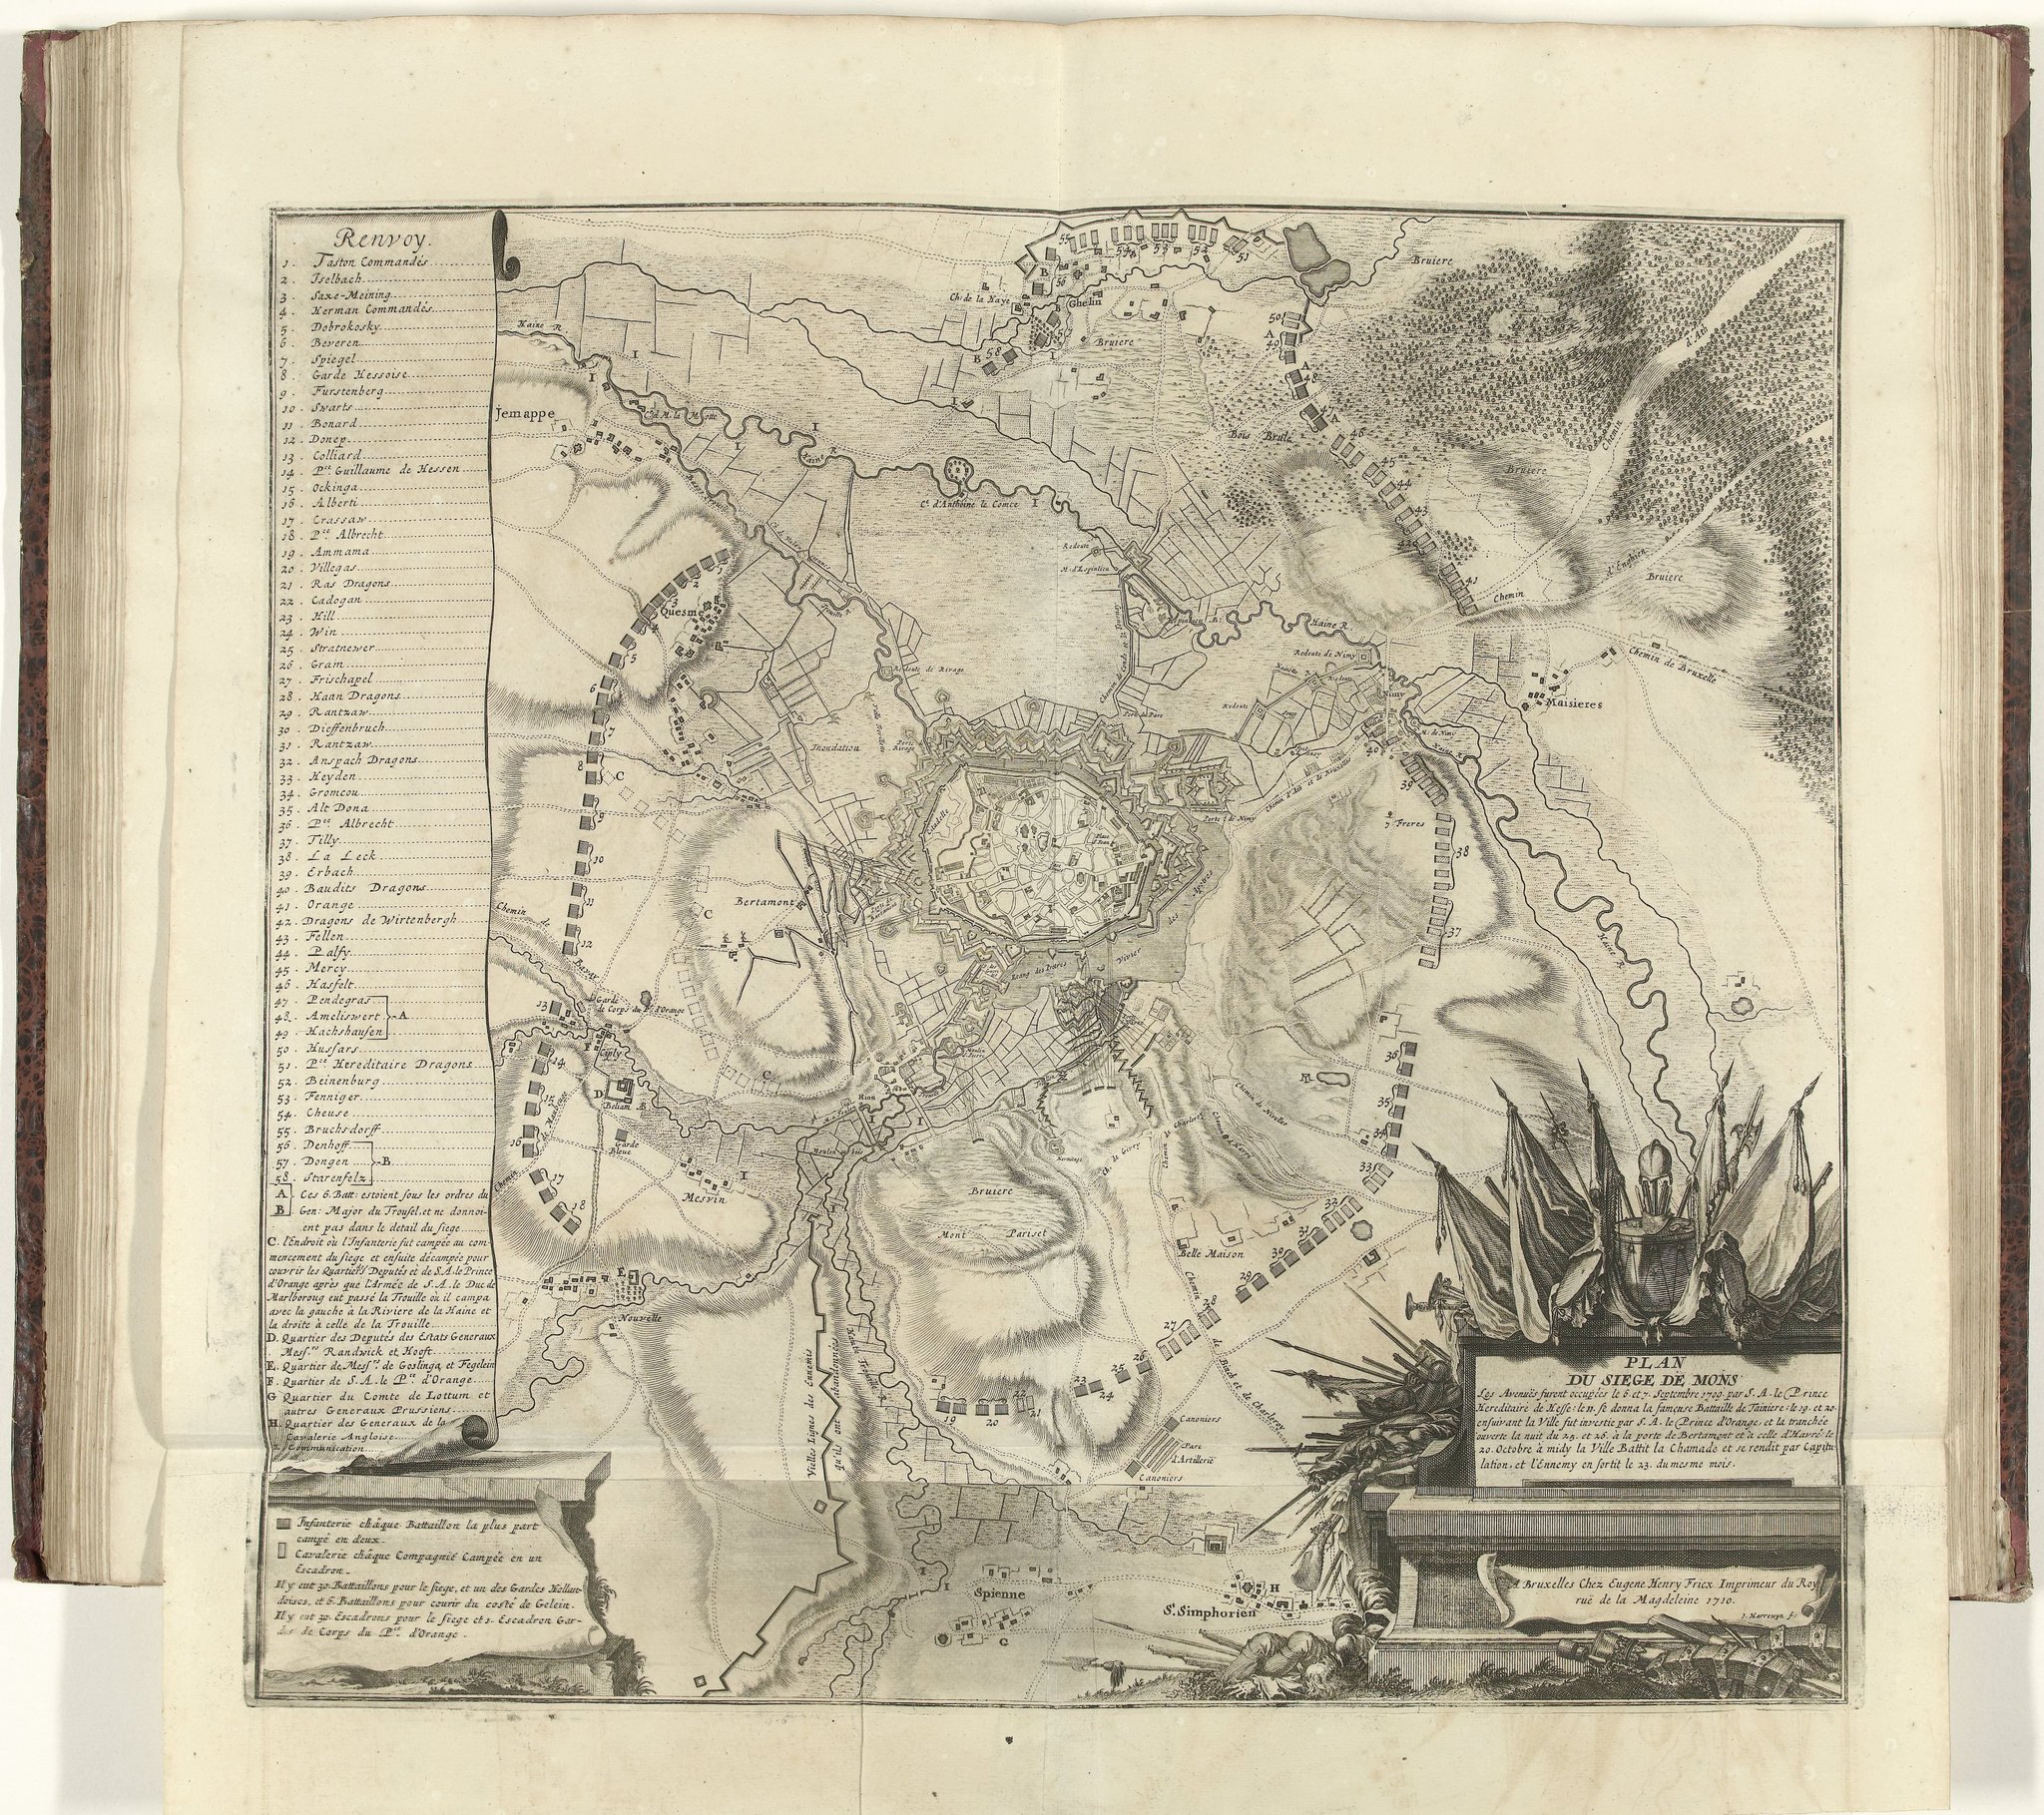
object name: map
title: Beleg van Mons, 1709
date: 1710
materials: paper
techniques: engraving, etching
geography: brussels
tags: maps of separate countries or regions, siege, position war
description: Kaart van het beleg en inname van Mons (Bergen) door de Geallieerden, 25 september - 22 oktober 1709. Rechtsonder een cartouche met de titel, versierd met wapens, vaandels en enkele lichamen van verslagen vijandelijke soldaten. Aan de linkerzijde de verklaring 1-58 en A-I in het Frans. Onderdeel van een gebundelde verzameling van plannen van veldslagen en steden vermaard in de Spaanse Successieoorlog.